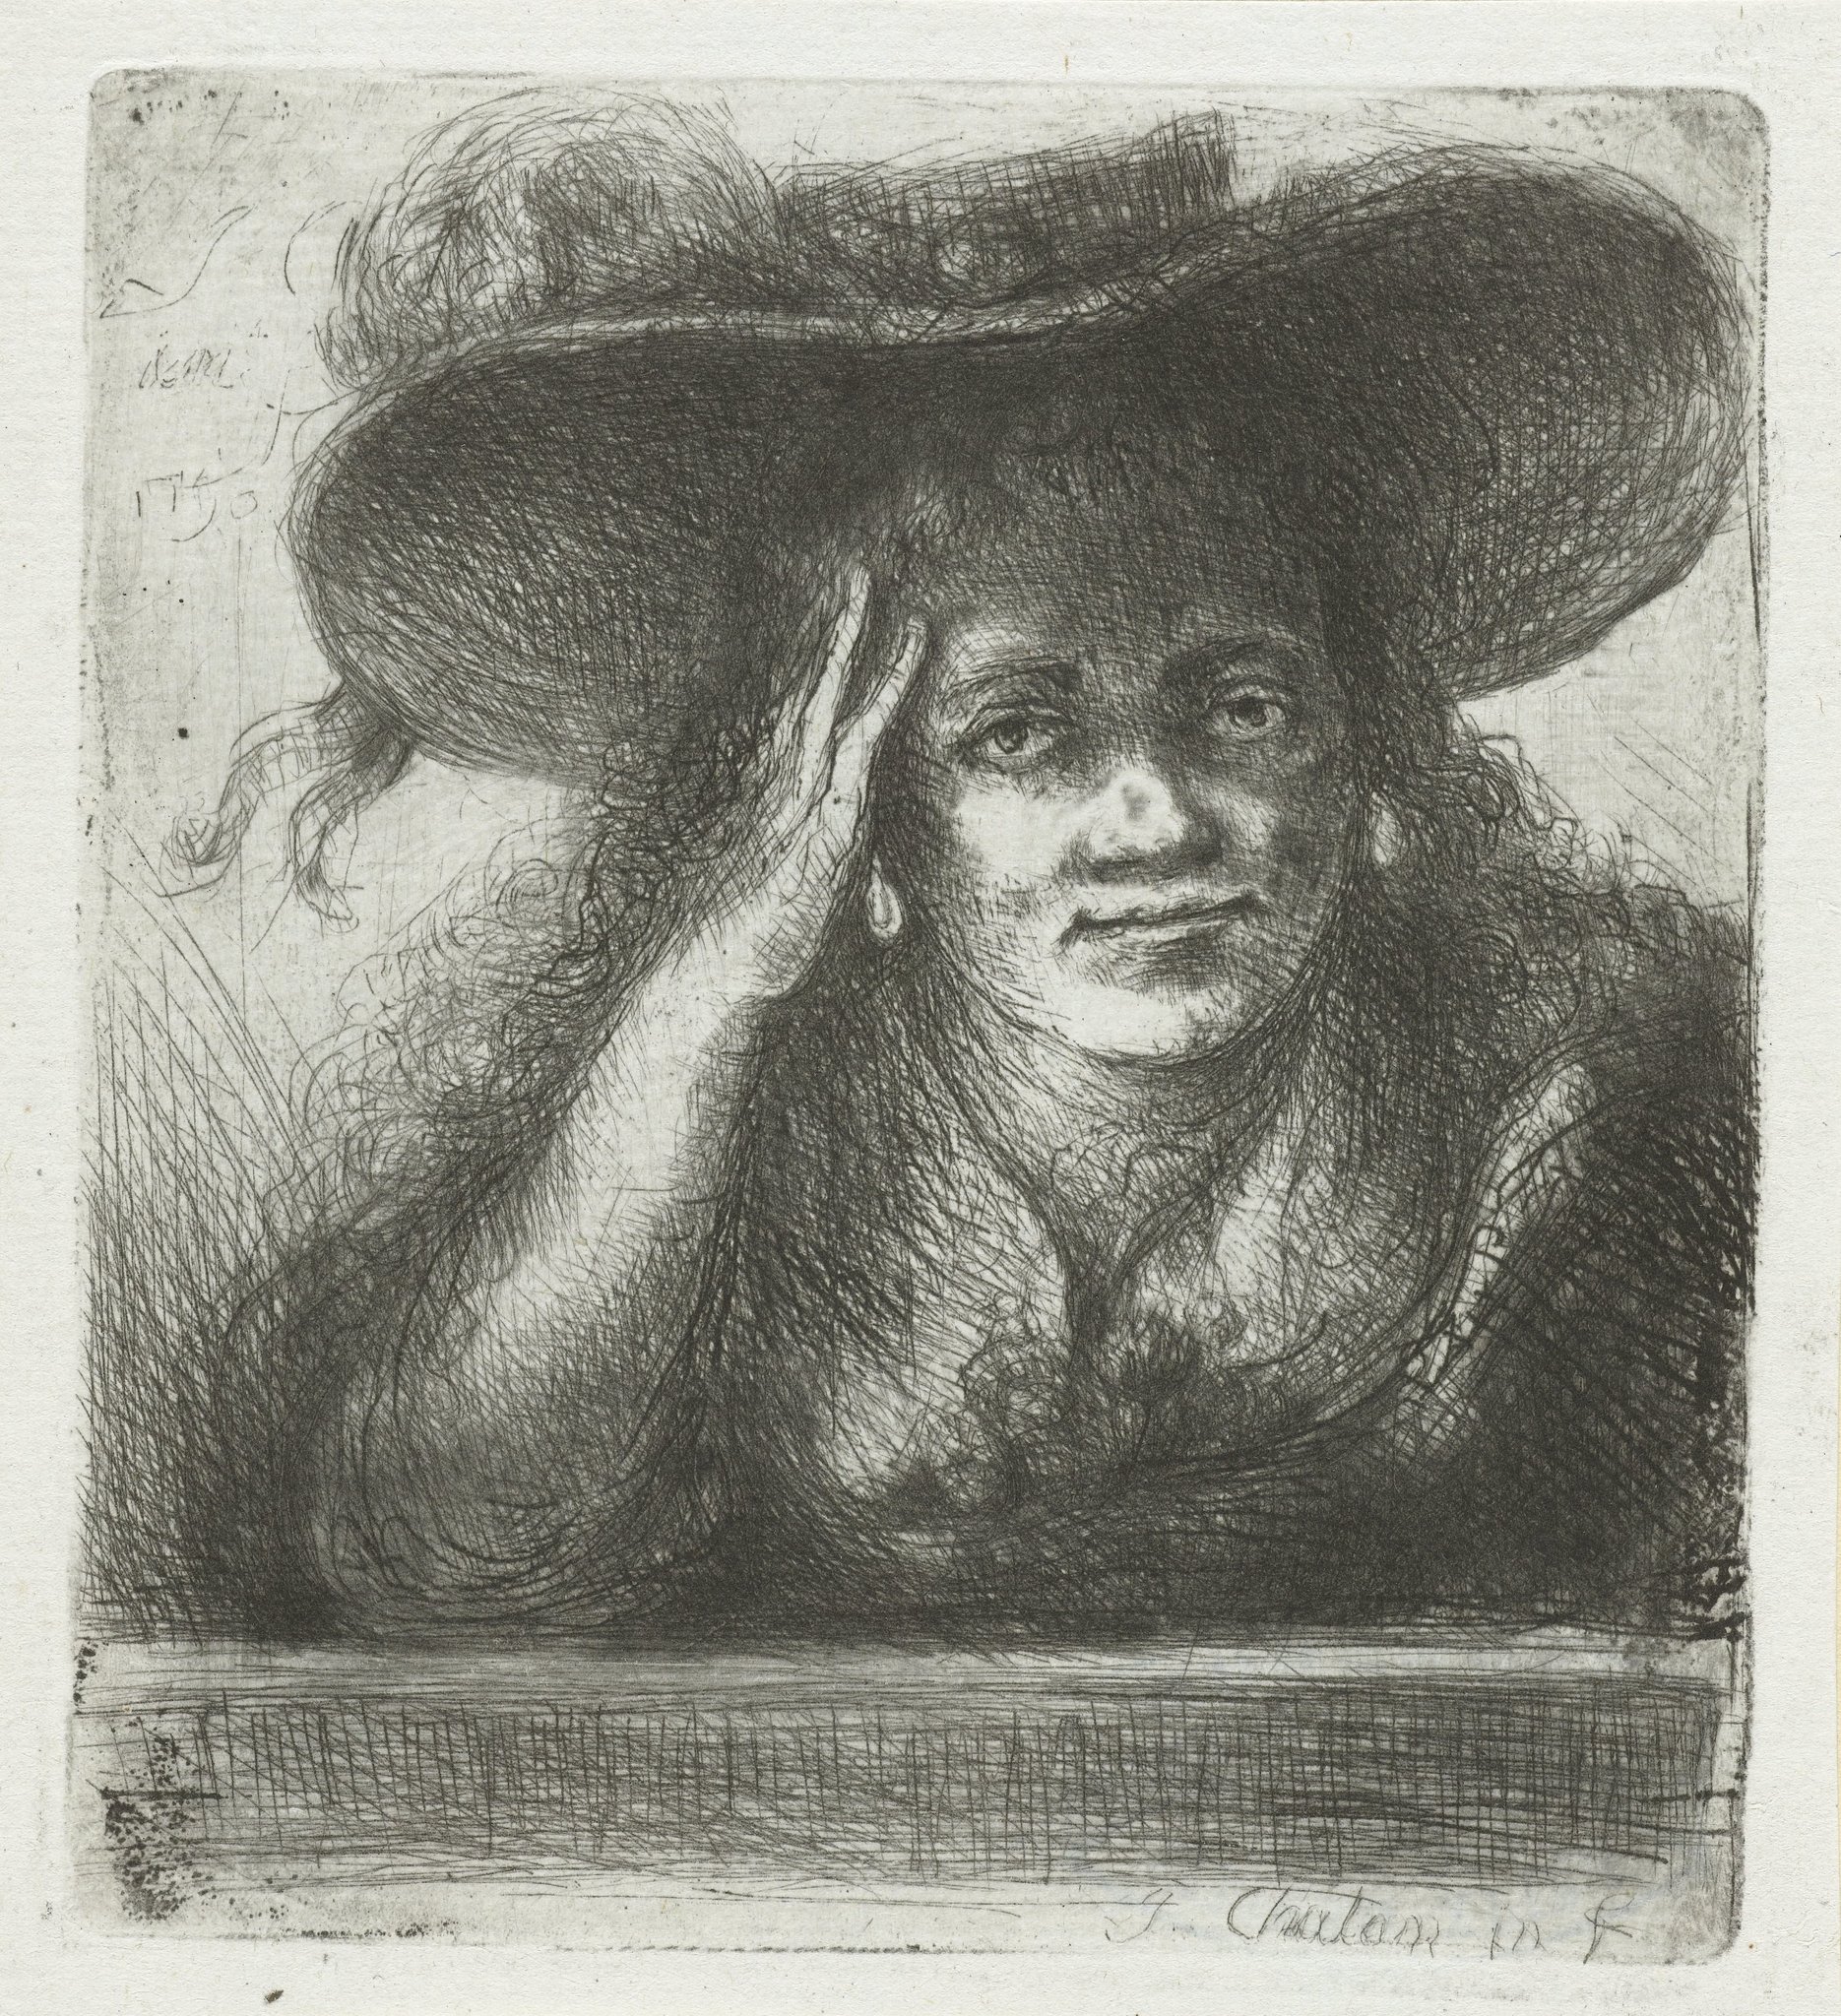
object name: print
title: Vrouw met grote ronde hoed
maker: jan chalon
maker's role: print maker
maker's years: 1738-1795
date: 1790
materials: paper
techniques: drypoint, etching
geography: northern netherlands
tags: head-gear, morphology of human expression (+ young female (human being))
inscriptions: collector's mark: Lugt 924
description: Vrouw met grote ronde hoed. Ze ondersteunt haar hoofd met haar rechterhand.